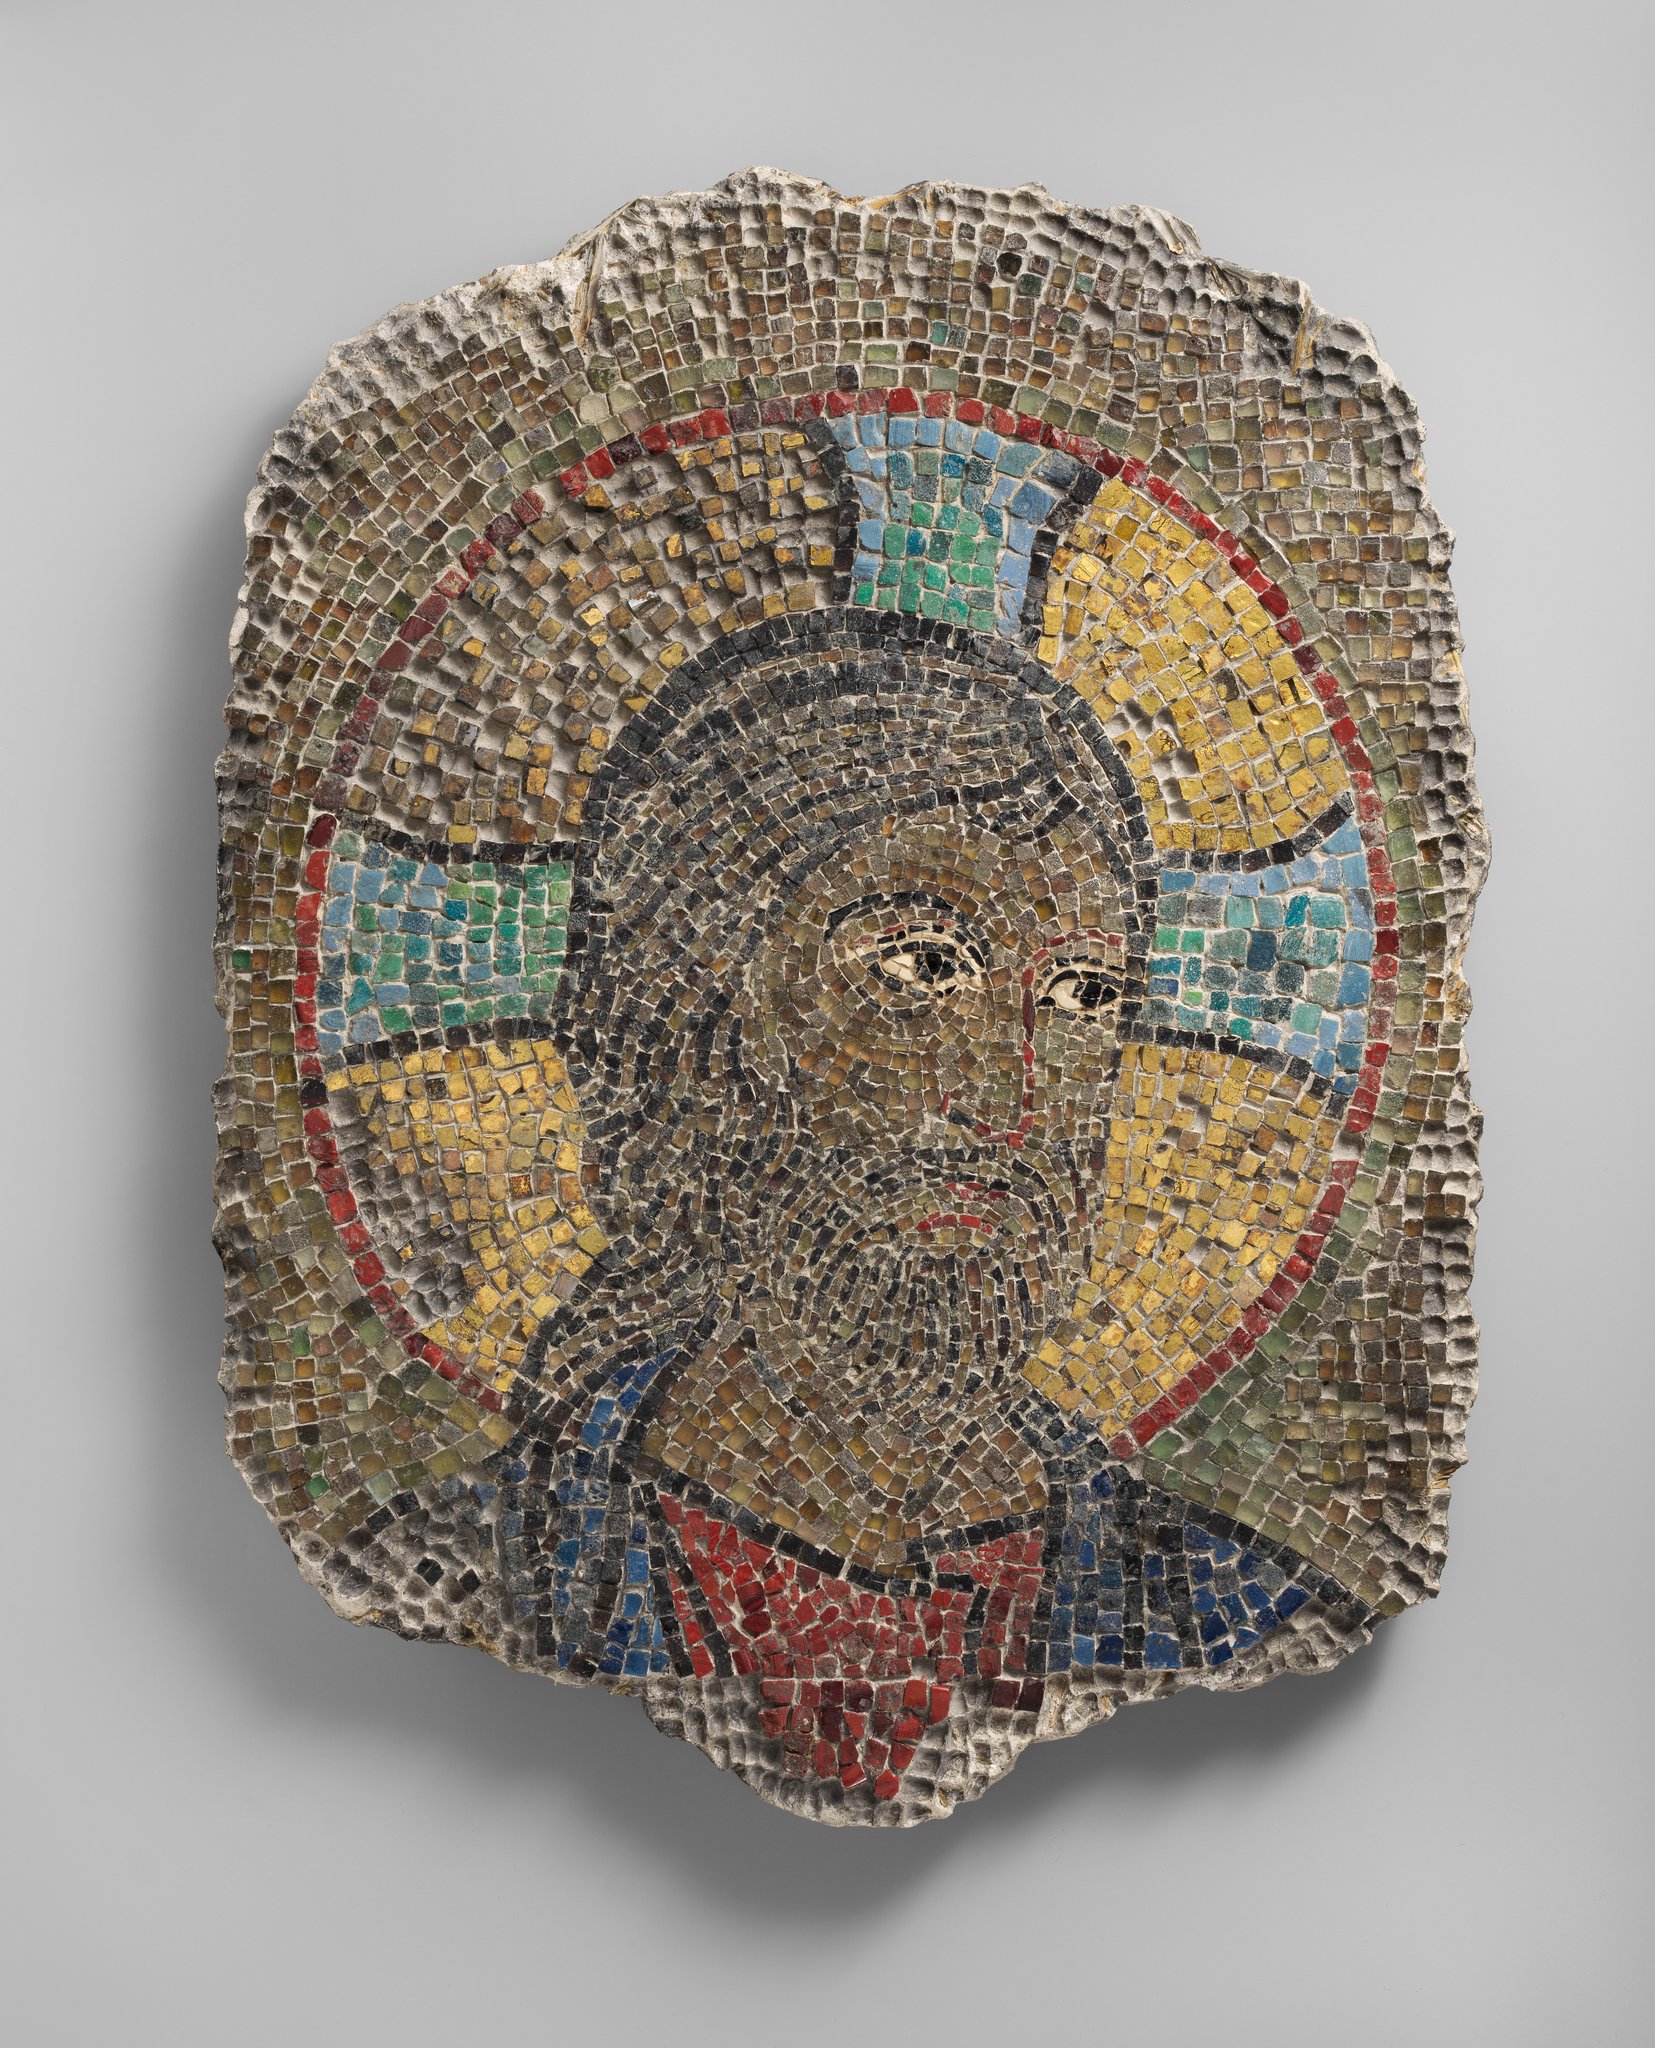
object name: mosaic, head of christ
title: Head of Christ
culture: byzantine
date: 1101-1200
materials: glass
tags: christ